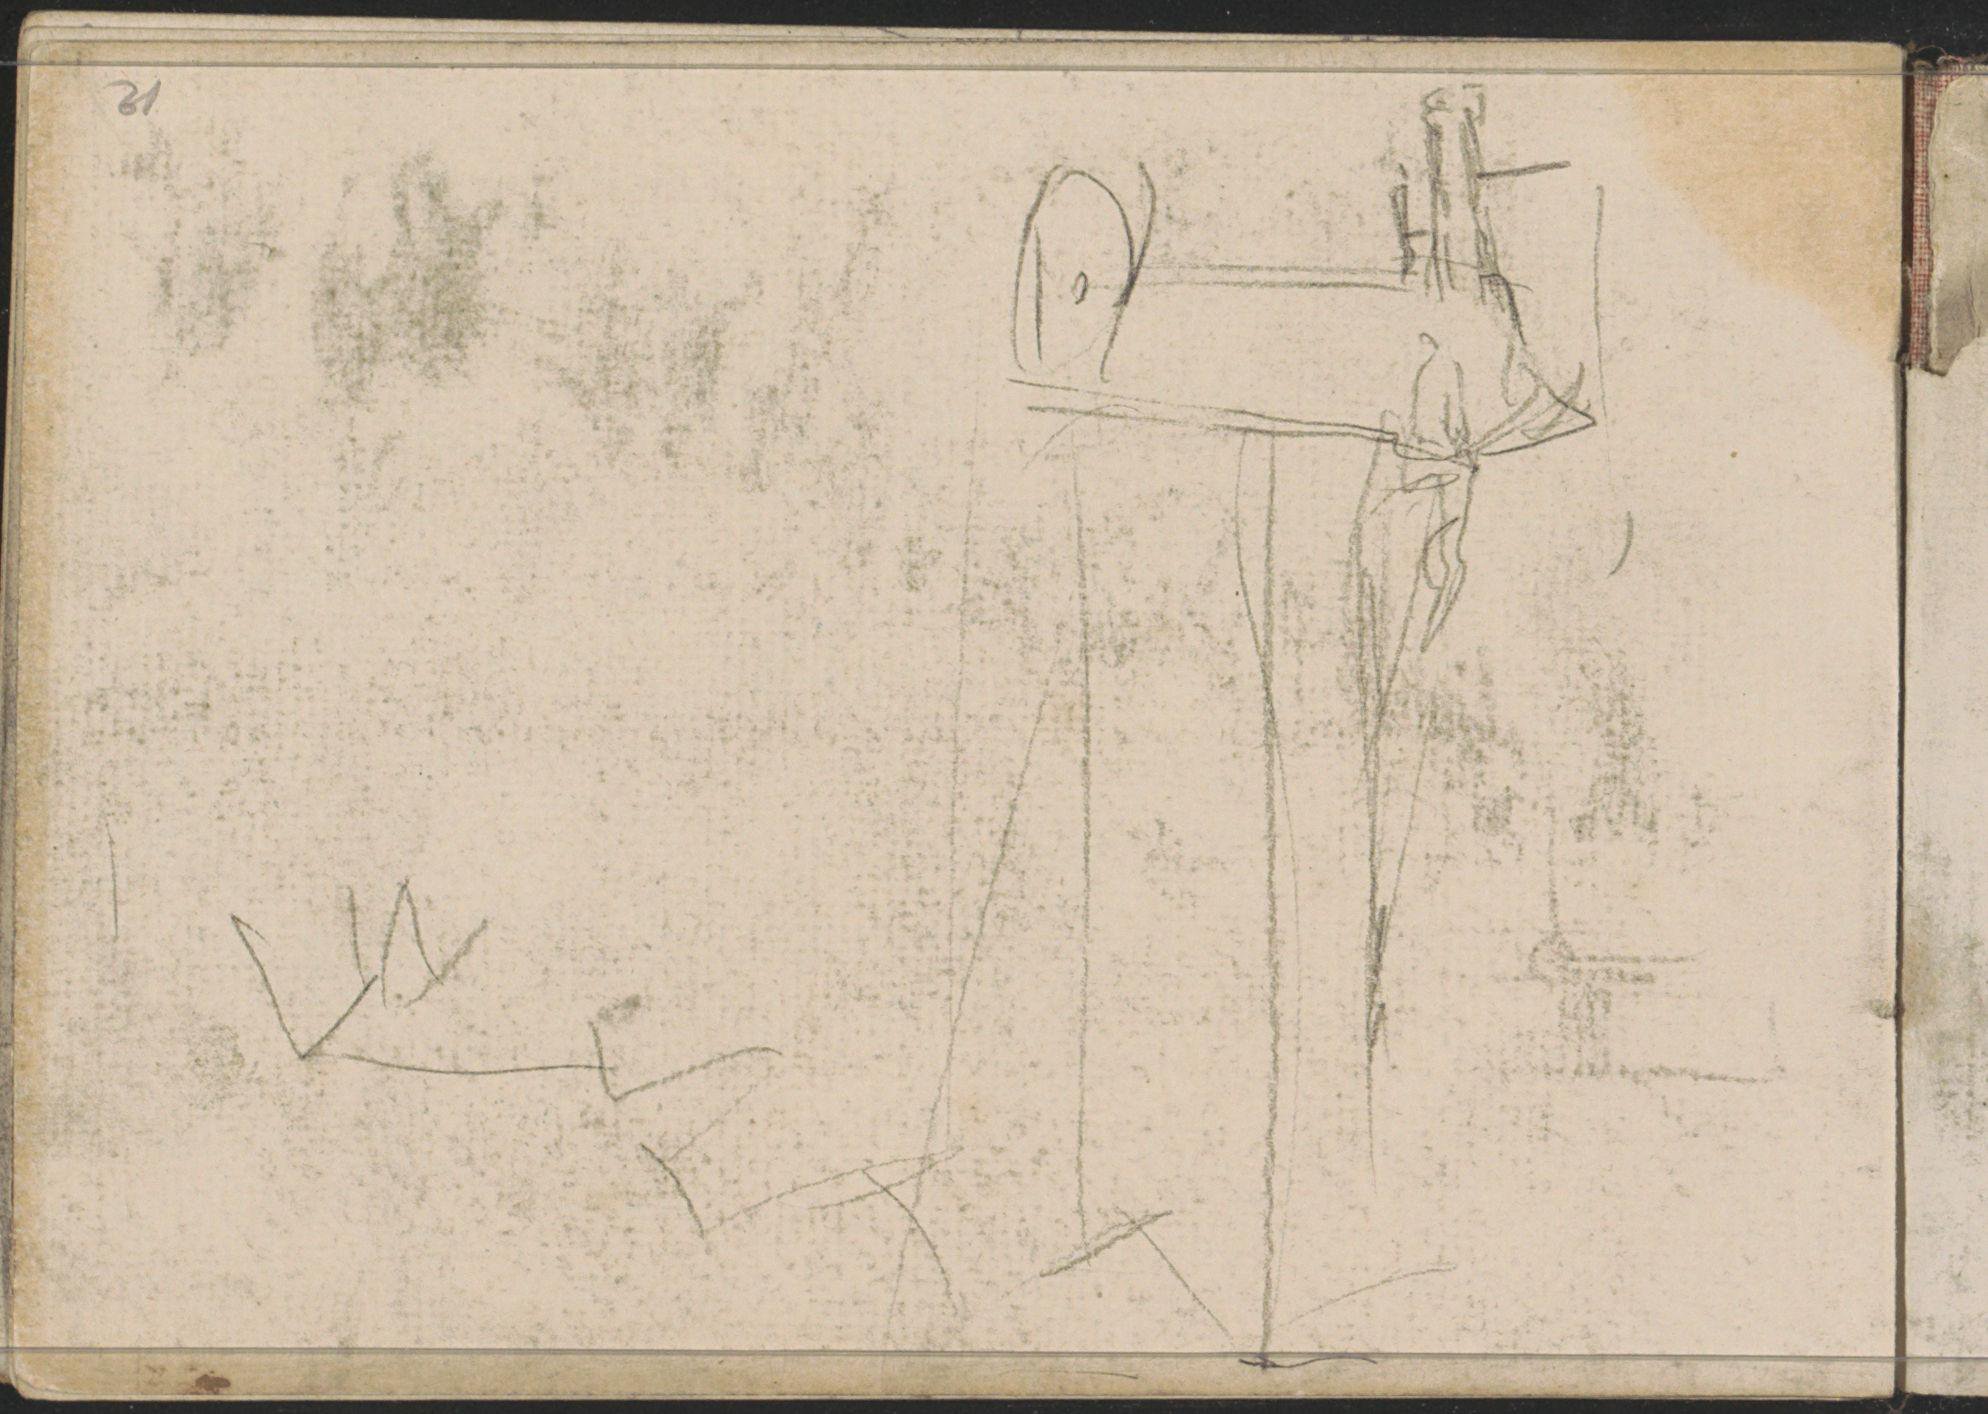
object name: sketchbook leaf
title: Stadsgezicht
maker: isaac israels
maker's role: draughtsman, painter, print maker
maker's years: 1865-1934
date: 1875-1934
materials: chalk, paper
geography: amsterdam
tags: civic architecture; edifices; dwellings, (farm) wagon, freight wagon, cart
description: Vooraan mogelijk een kar. Blad 9 verso uit schetsboek XXXI met 10 bladen.